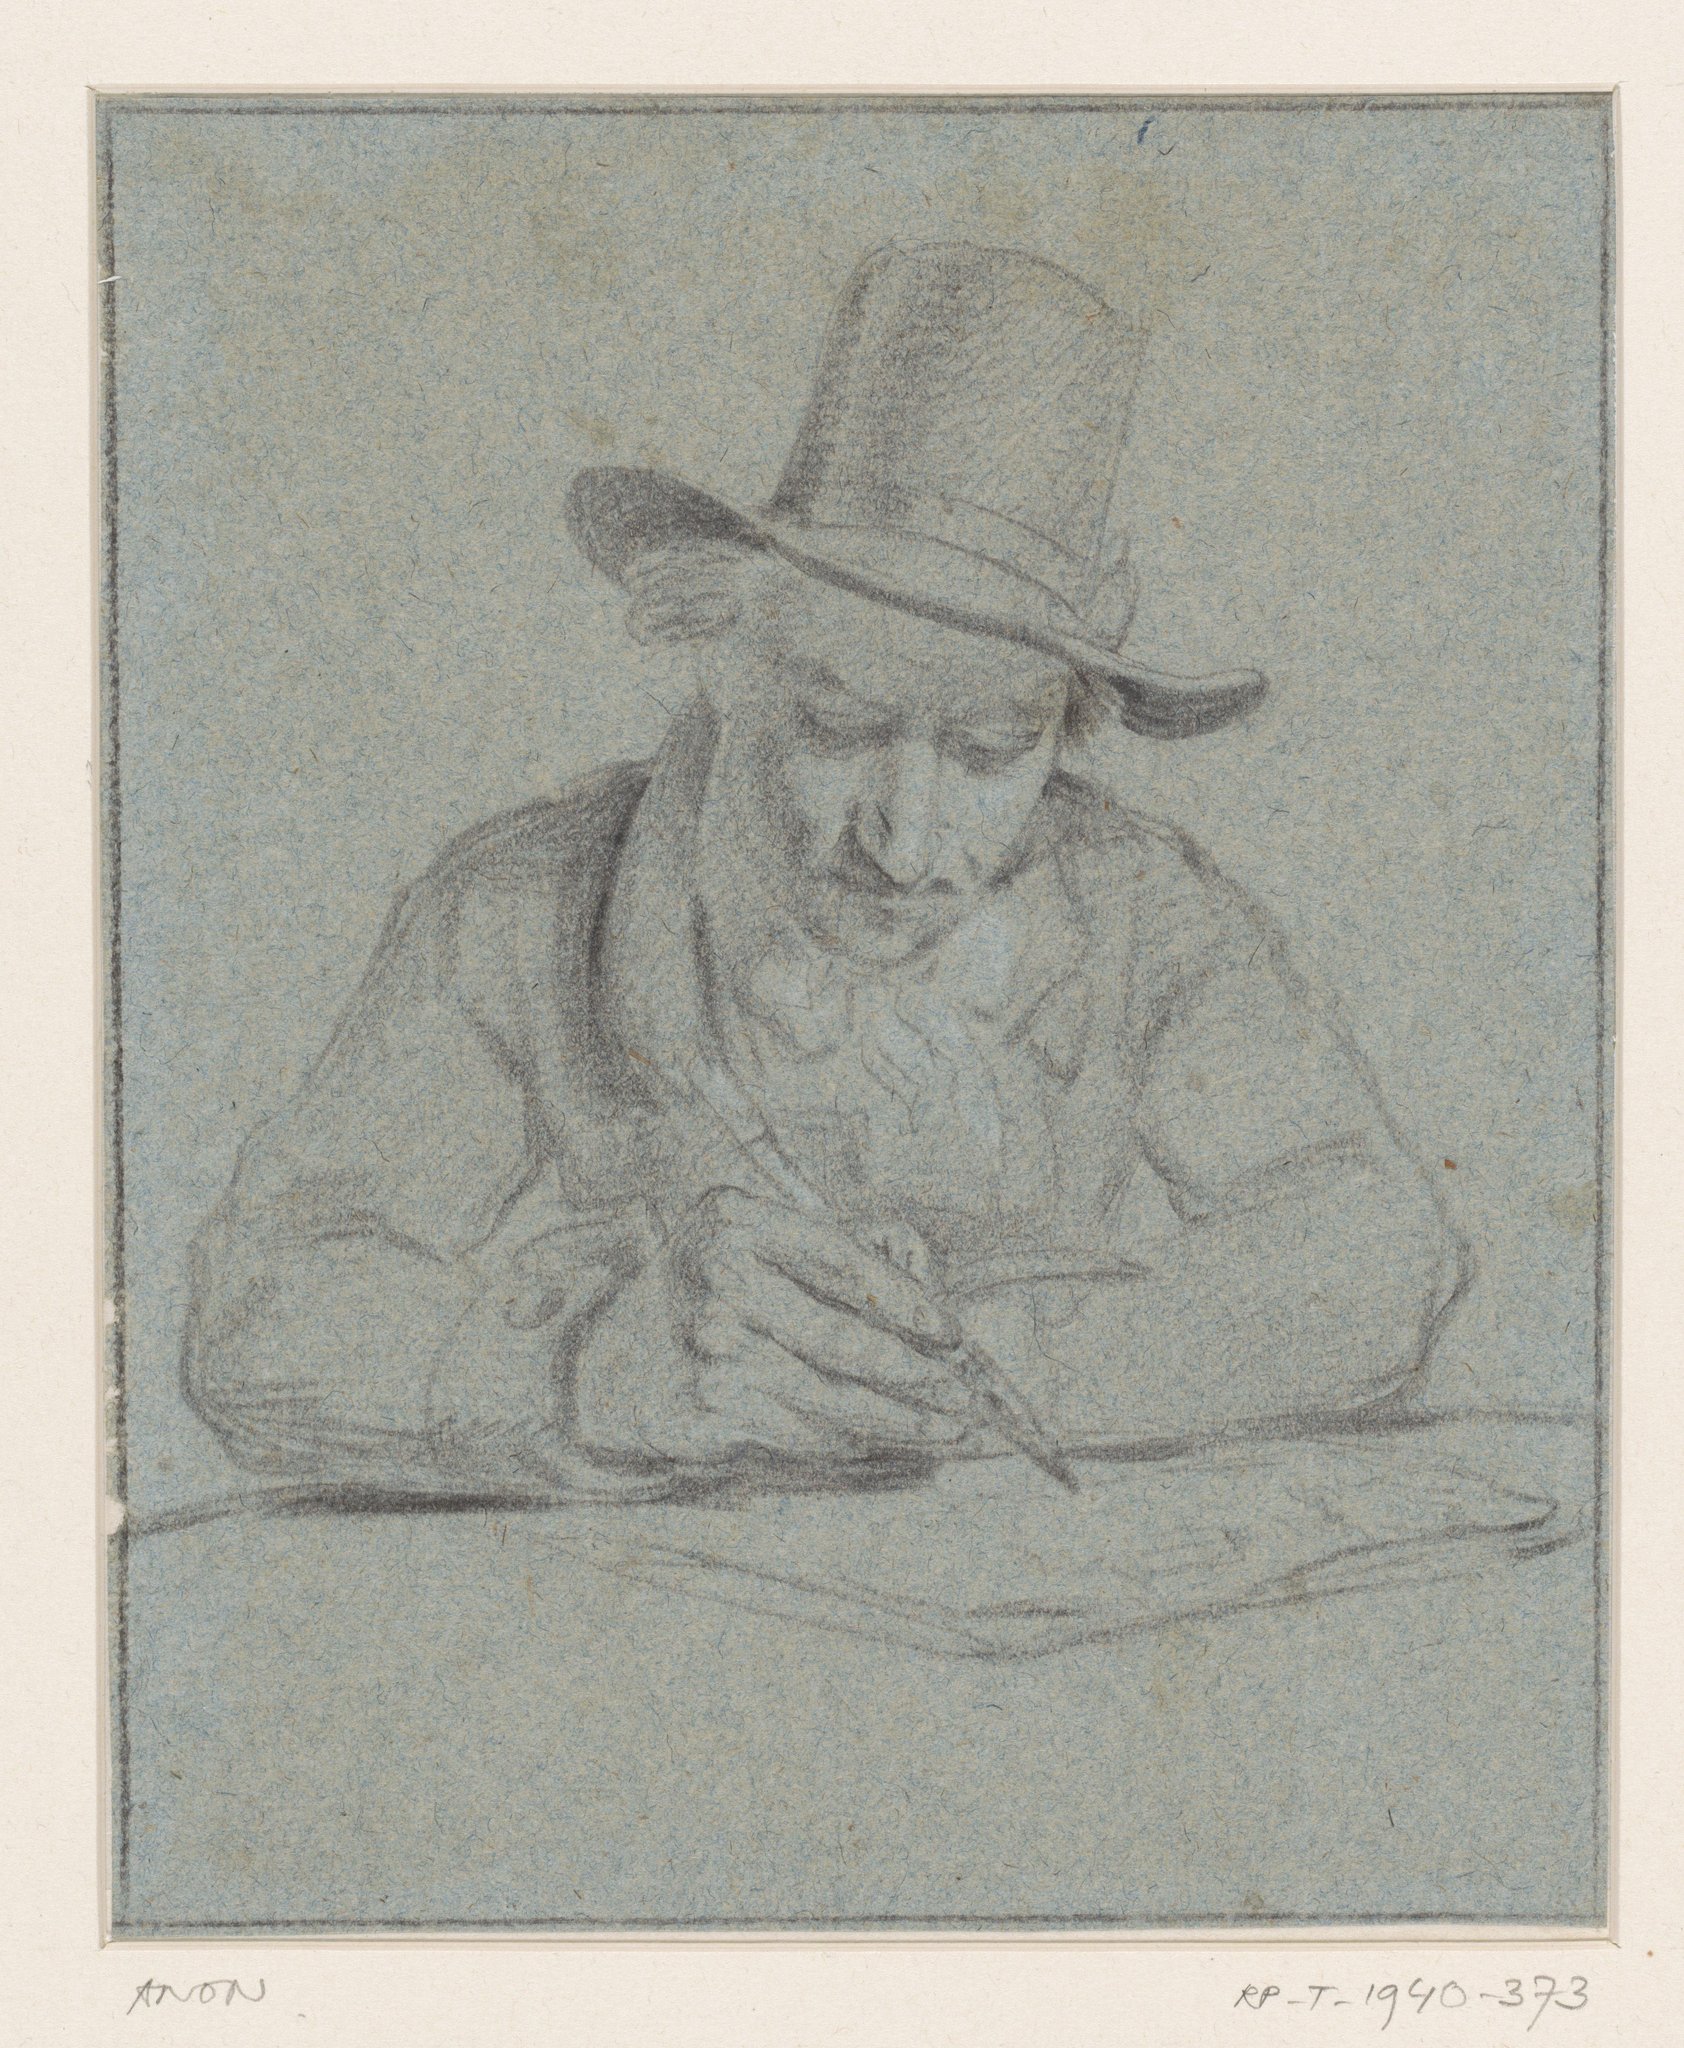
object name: drawing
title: Portret van Antoine Daniel Prudhomme, tekenend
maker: Anonymous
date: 1755-1876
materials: chalk, paper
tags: draughtsman, antoine daniel prudhomme, historical persons, draughtsman at work, portrait, self-portrait of artist, portrait, self-portrait of draughtsman